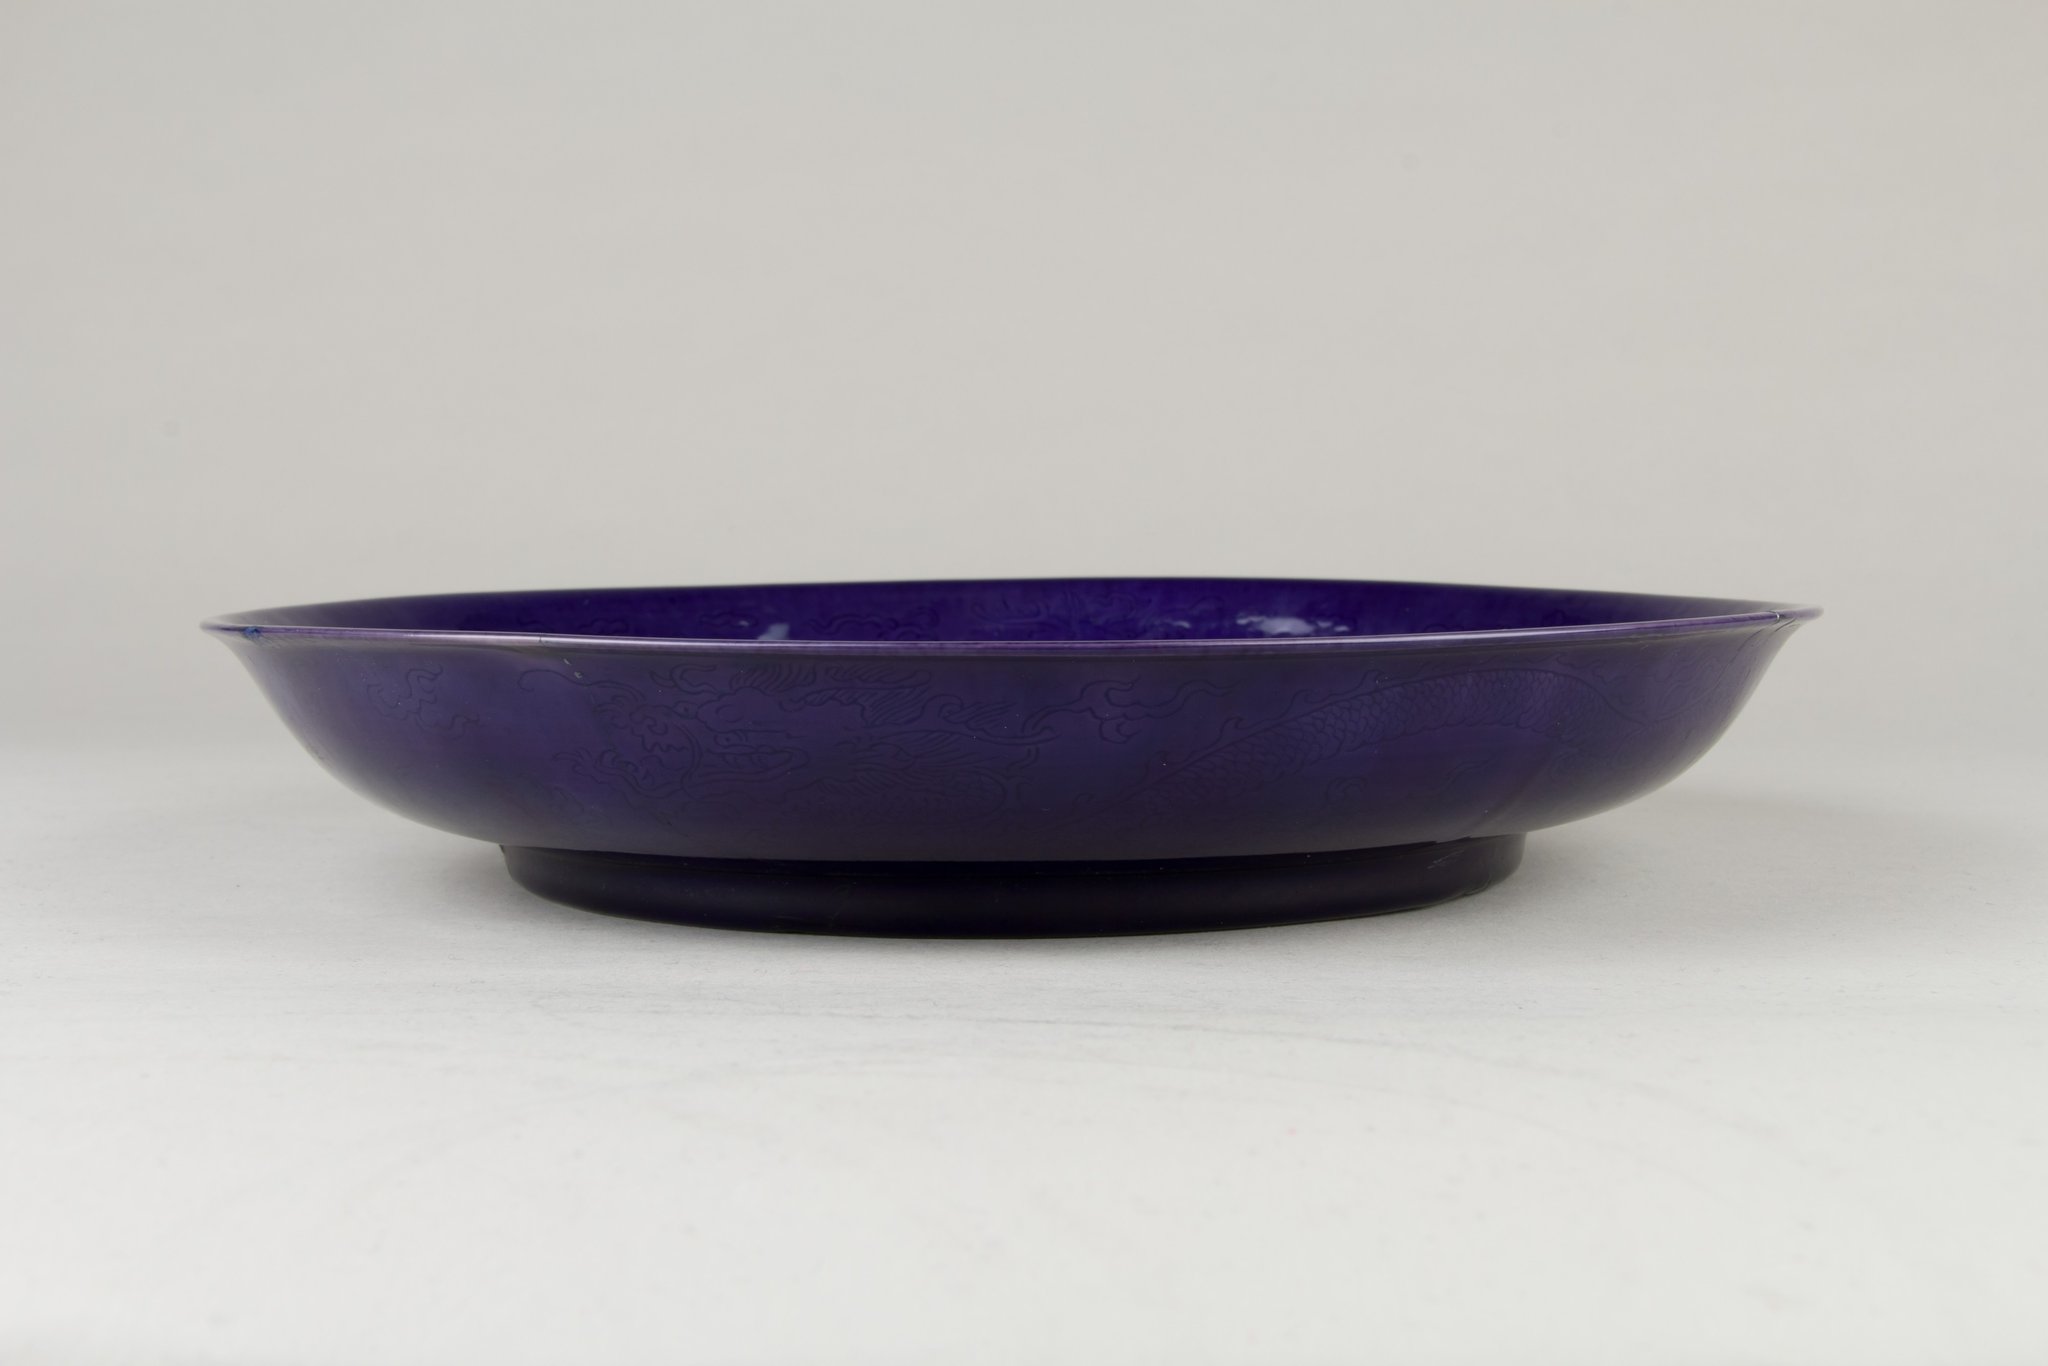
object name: plate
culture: chinese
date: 1662-1722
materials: porcelain